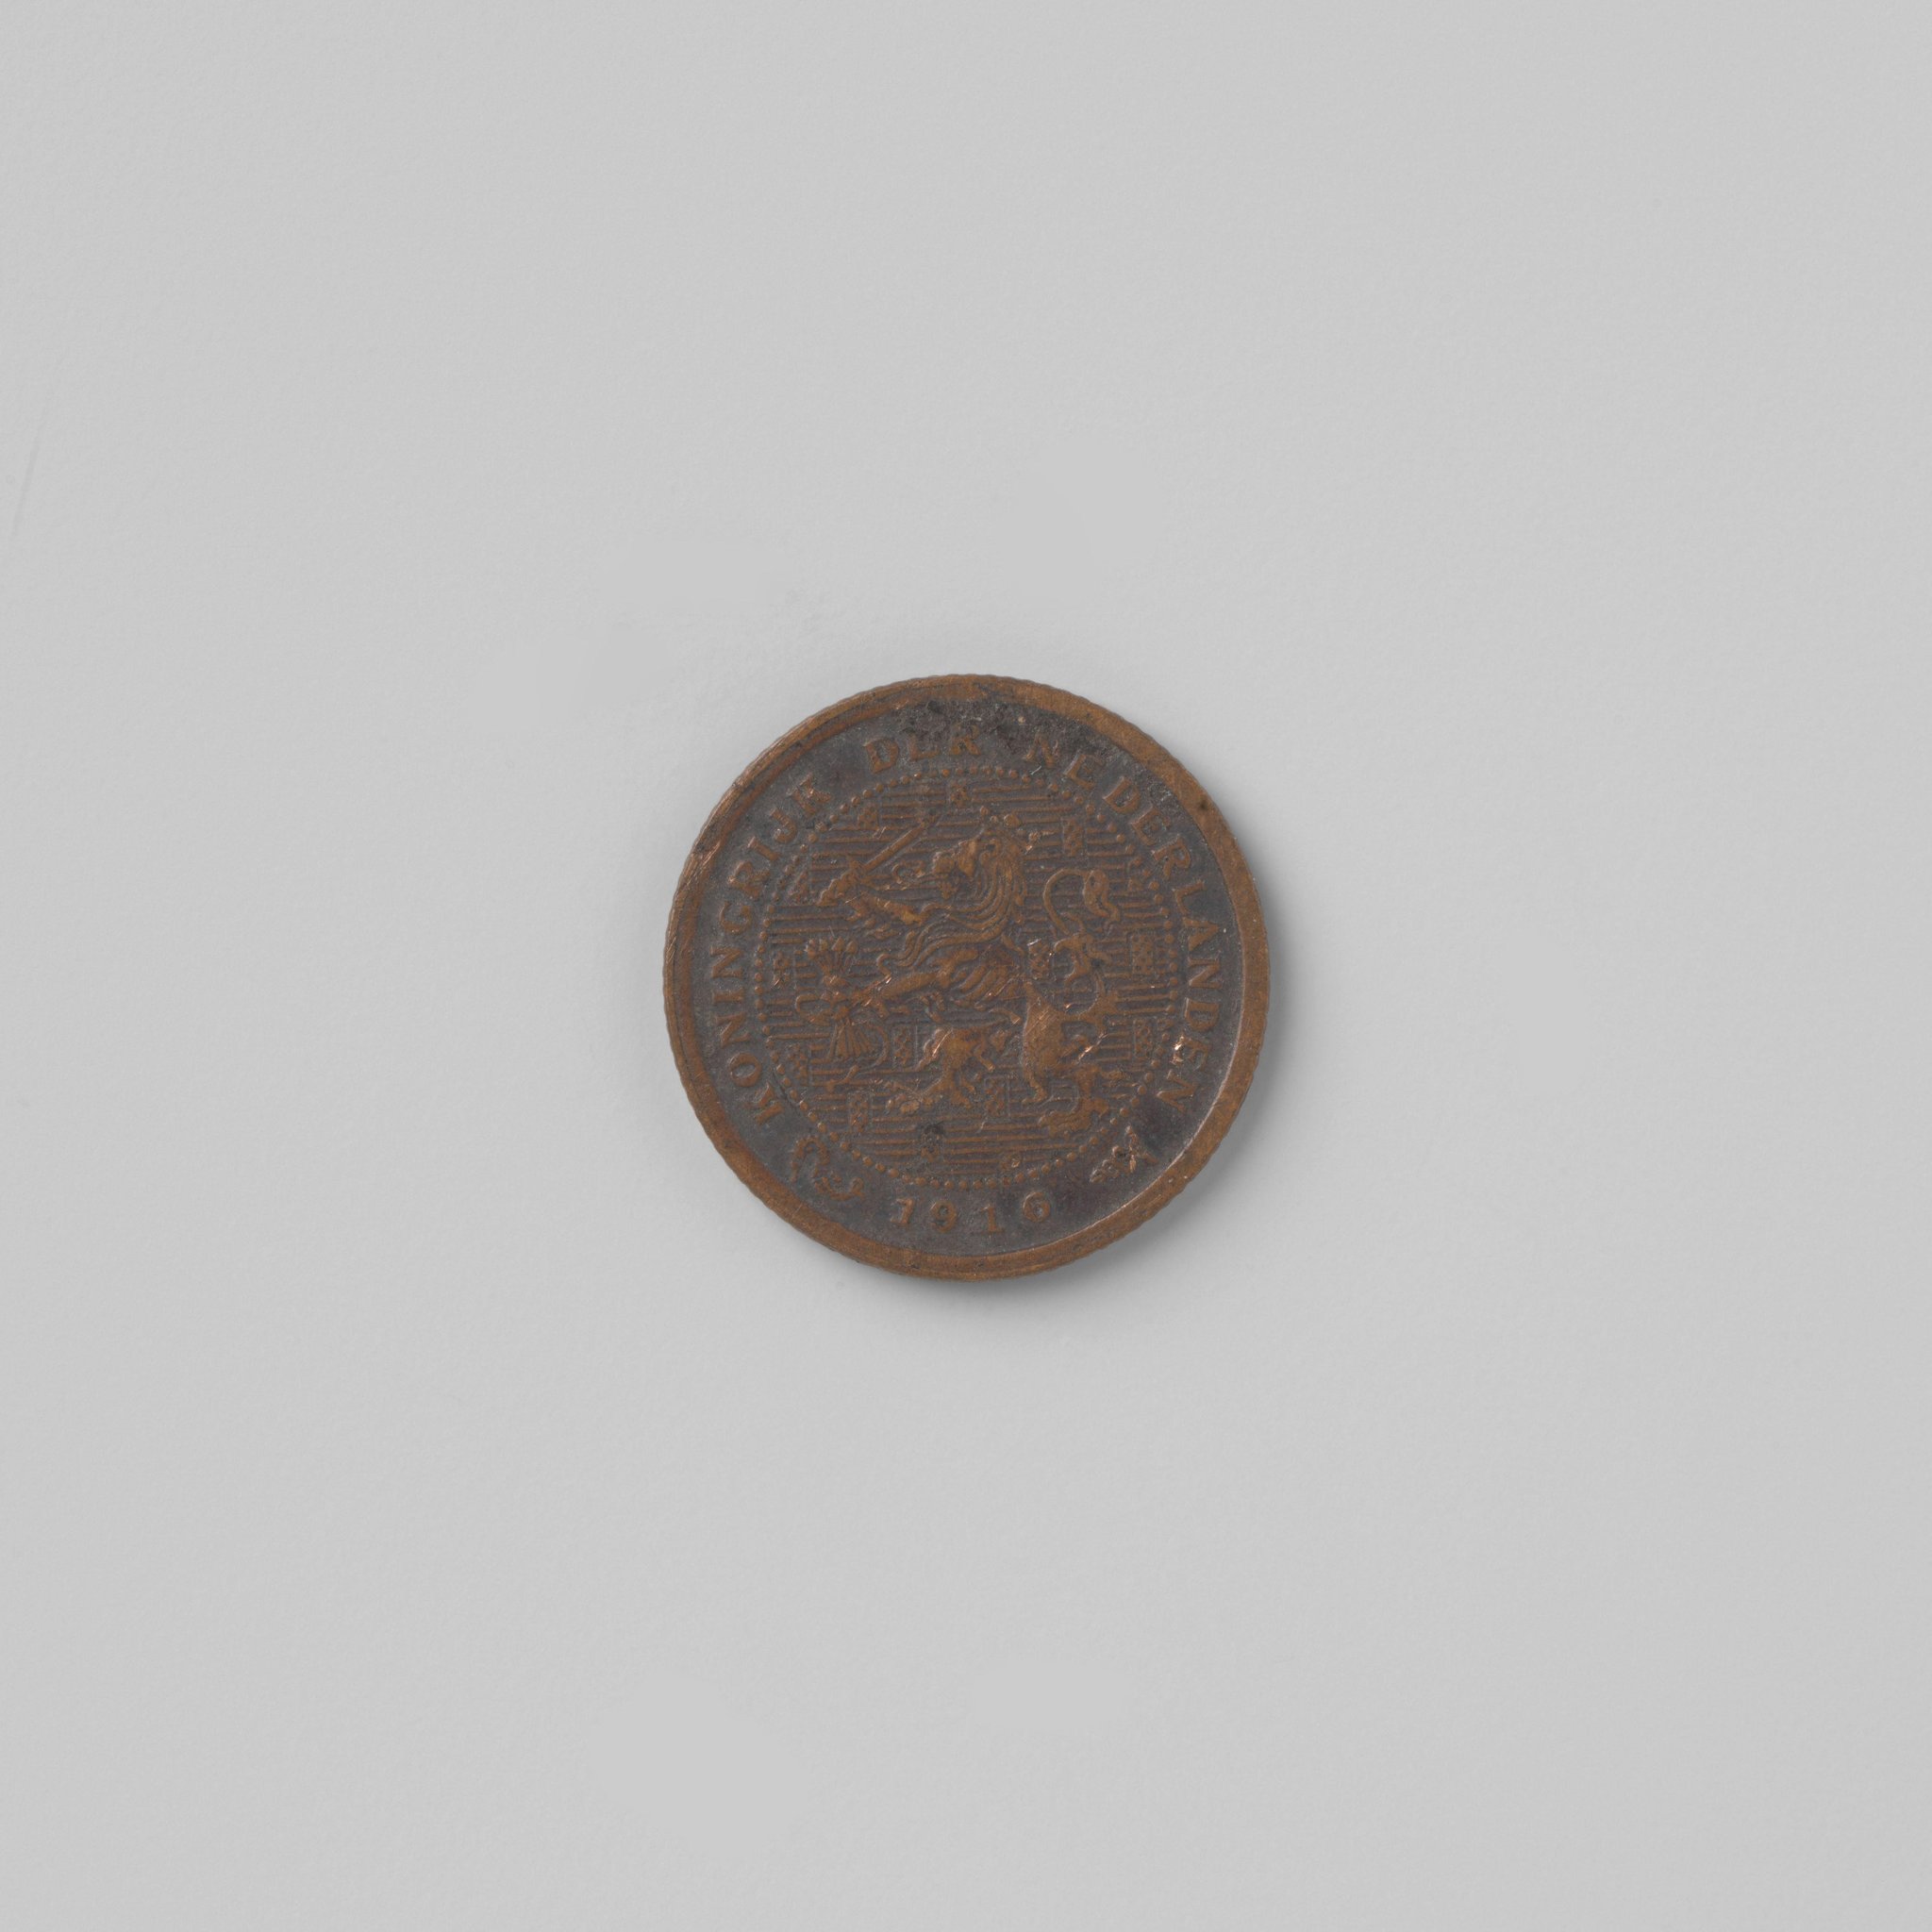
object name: coin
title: Nederland, ½ cent,1916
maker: wilhelmina of the netherlands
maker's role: print maker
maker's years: 1880-1962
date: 1916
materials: bronze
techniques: striking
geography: utrecht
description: Bronzen munt. Voorzijde: in een veld rijkswapen. Jaartal onderaan in omschrift. Keerzijde: binnen twee samengebonden oranjetakken waarde-aanduiding ½ cent. Kartelrand.